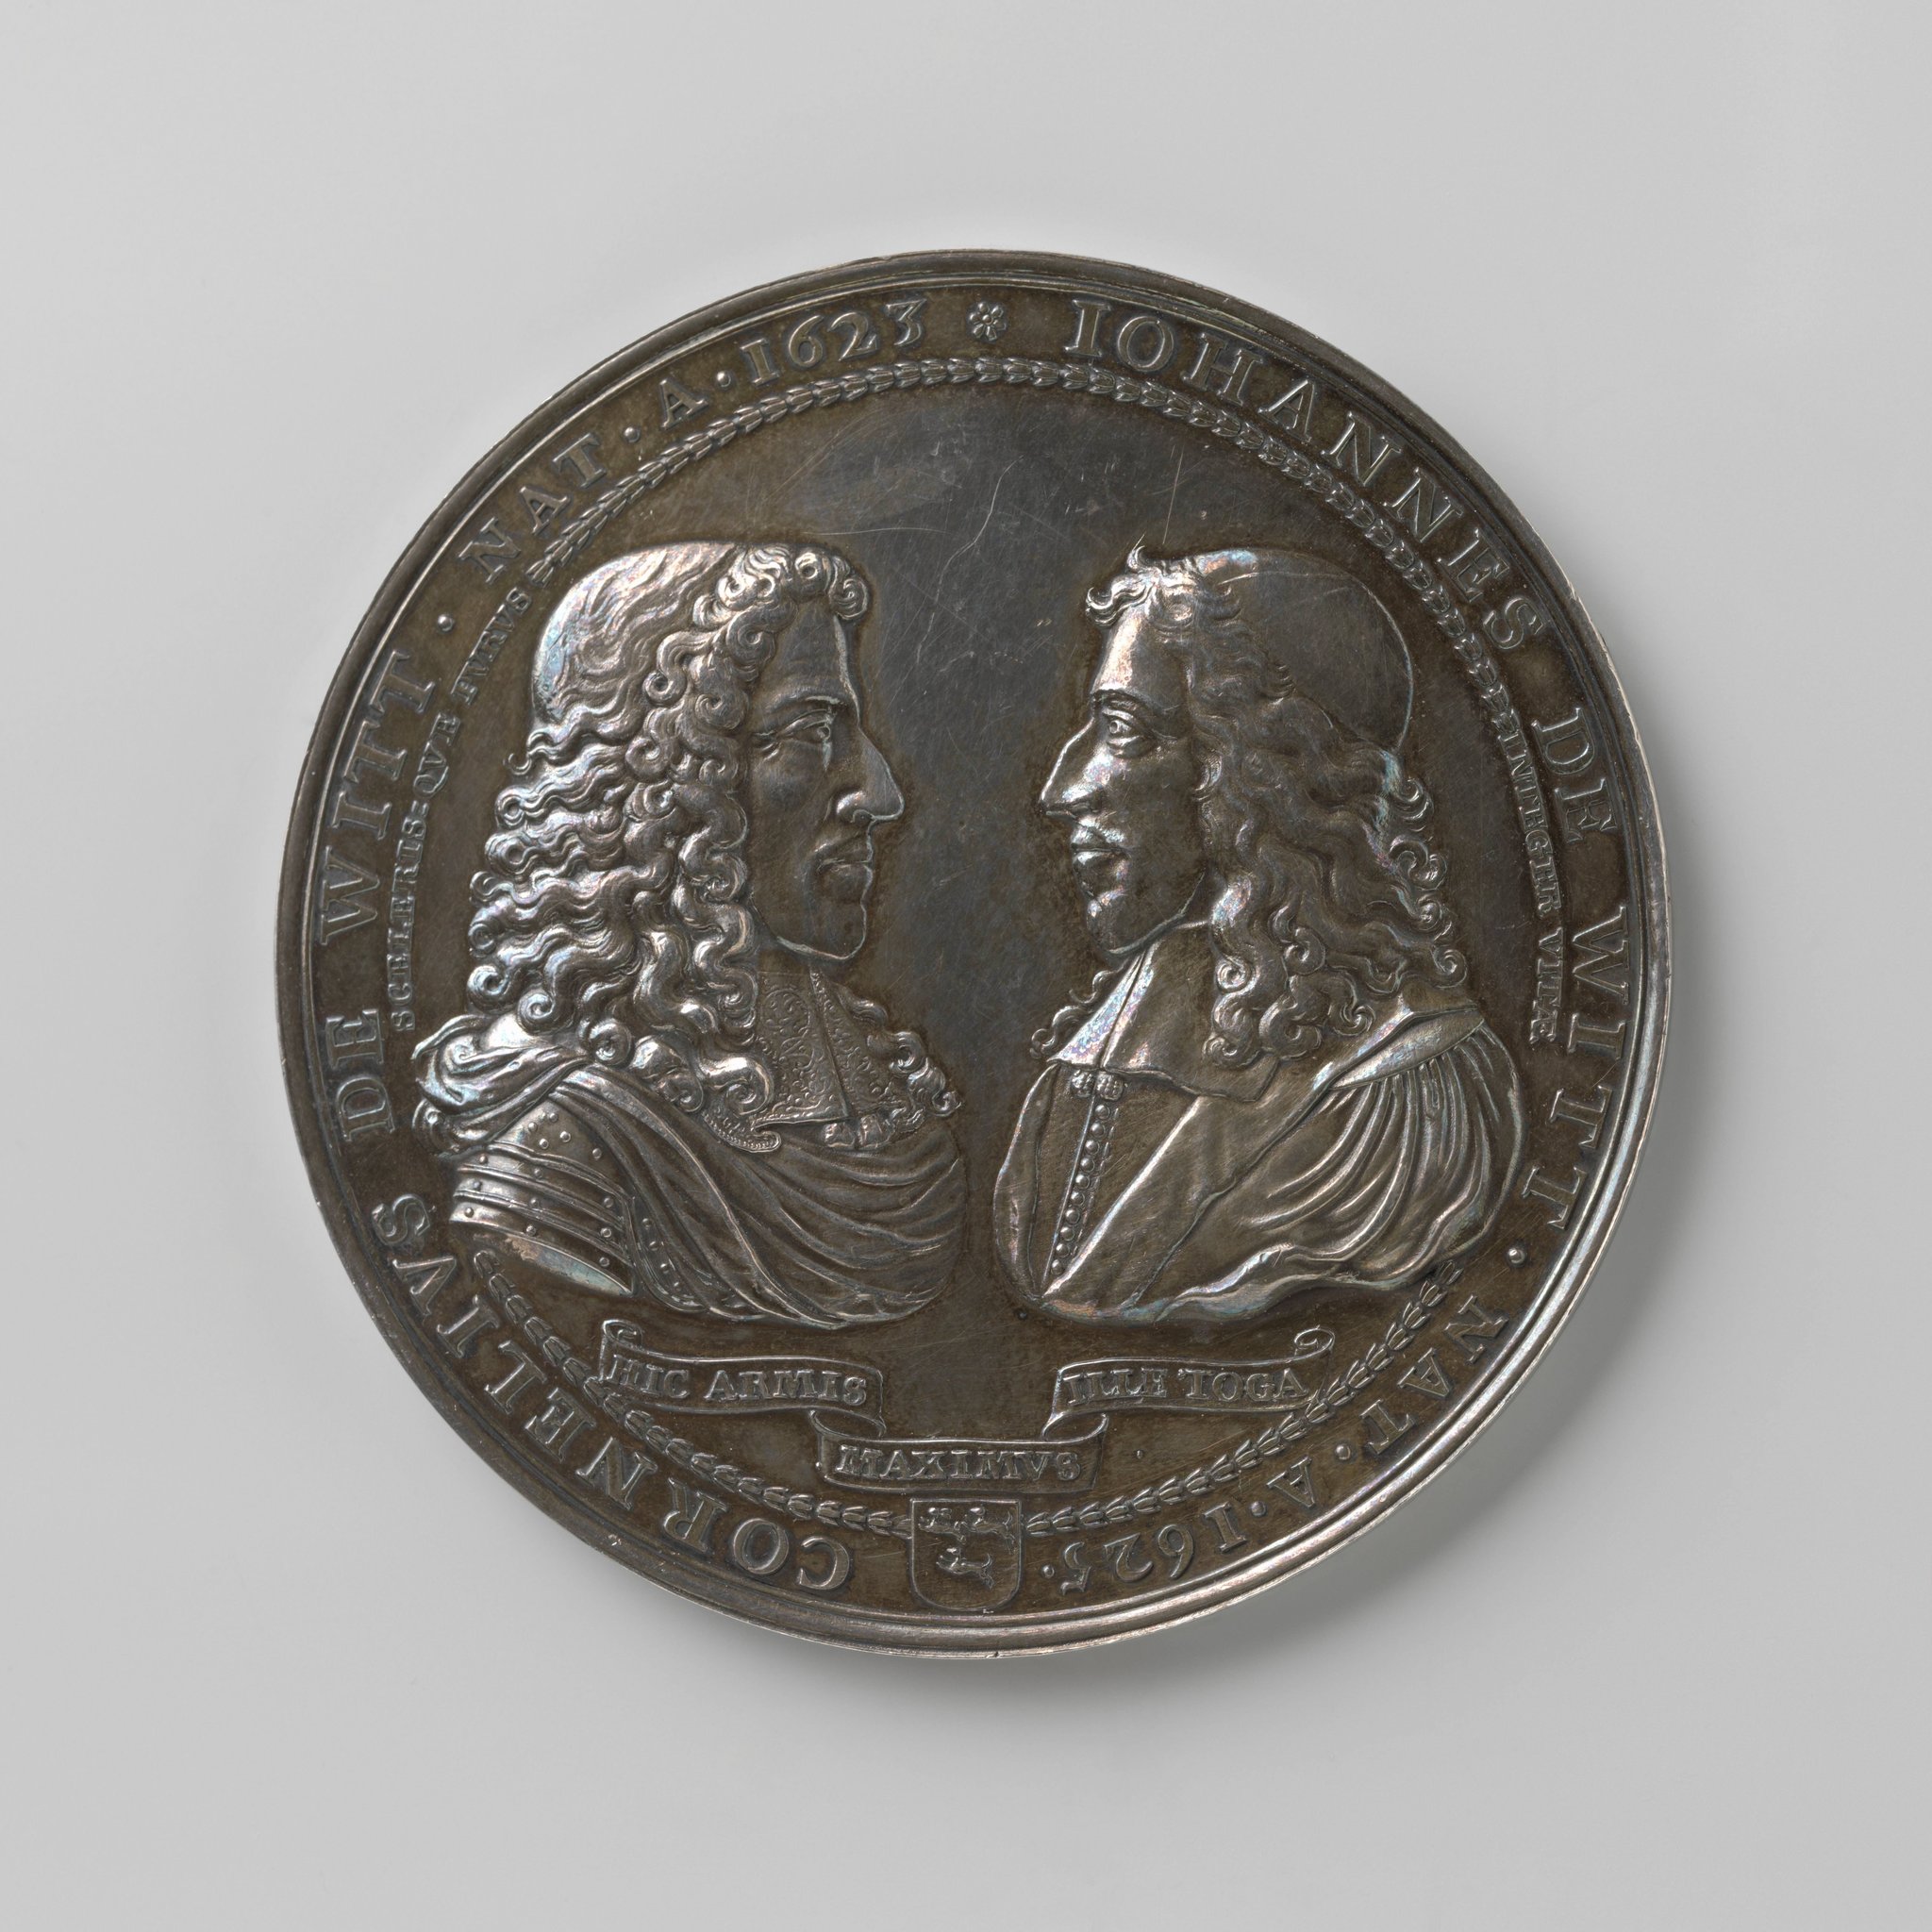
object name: history medal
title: Moord op de gebroeders De Witt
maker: pierre aury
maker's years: 1622-1692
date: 1672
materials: wood, paper, silver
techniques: striking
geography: netherlands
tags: dordrecht, cornelis de witt, the hague, politician, johan de witt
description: Zilveren gedenkpenning op de moord op Johan en Cornelis de Witt. Voorzijde: binnen omschrift naar elkaar gekeerd de busten van twee mannen, waaronder een banderol met opschrift. Keerzijde: binnen omschrift twee naakte mannen door wilde dieren verscheurd, waaronder opschrift. Met bijbehorende doos NG-2014-3-2.